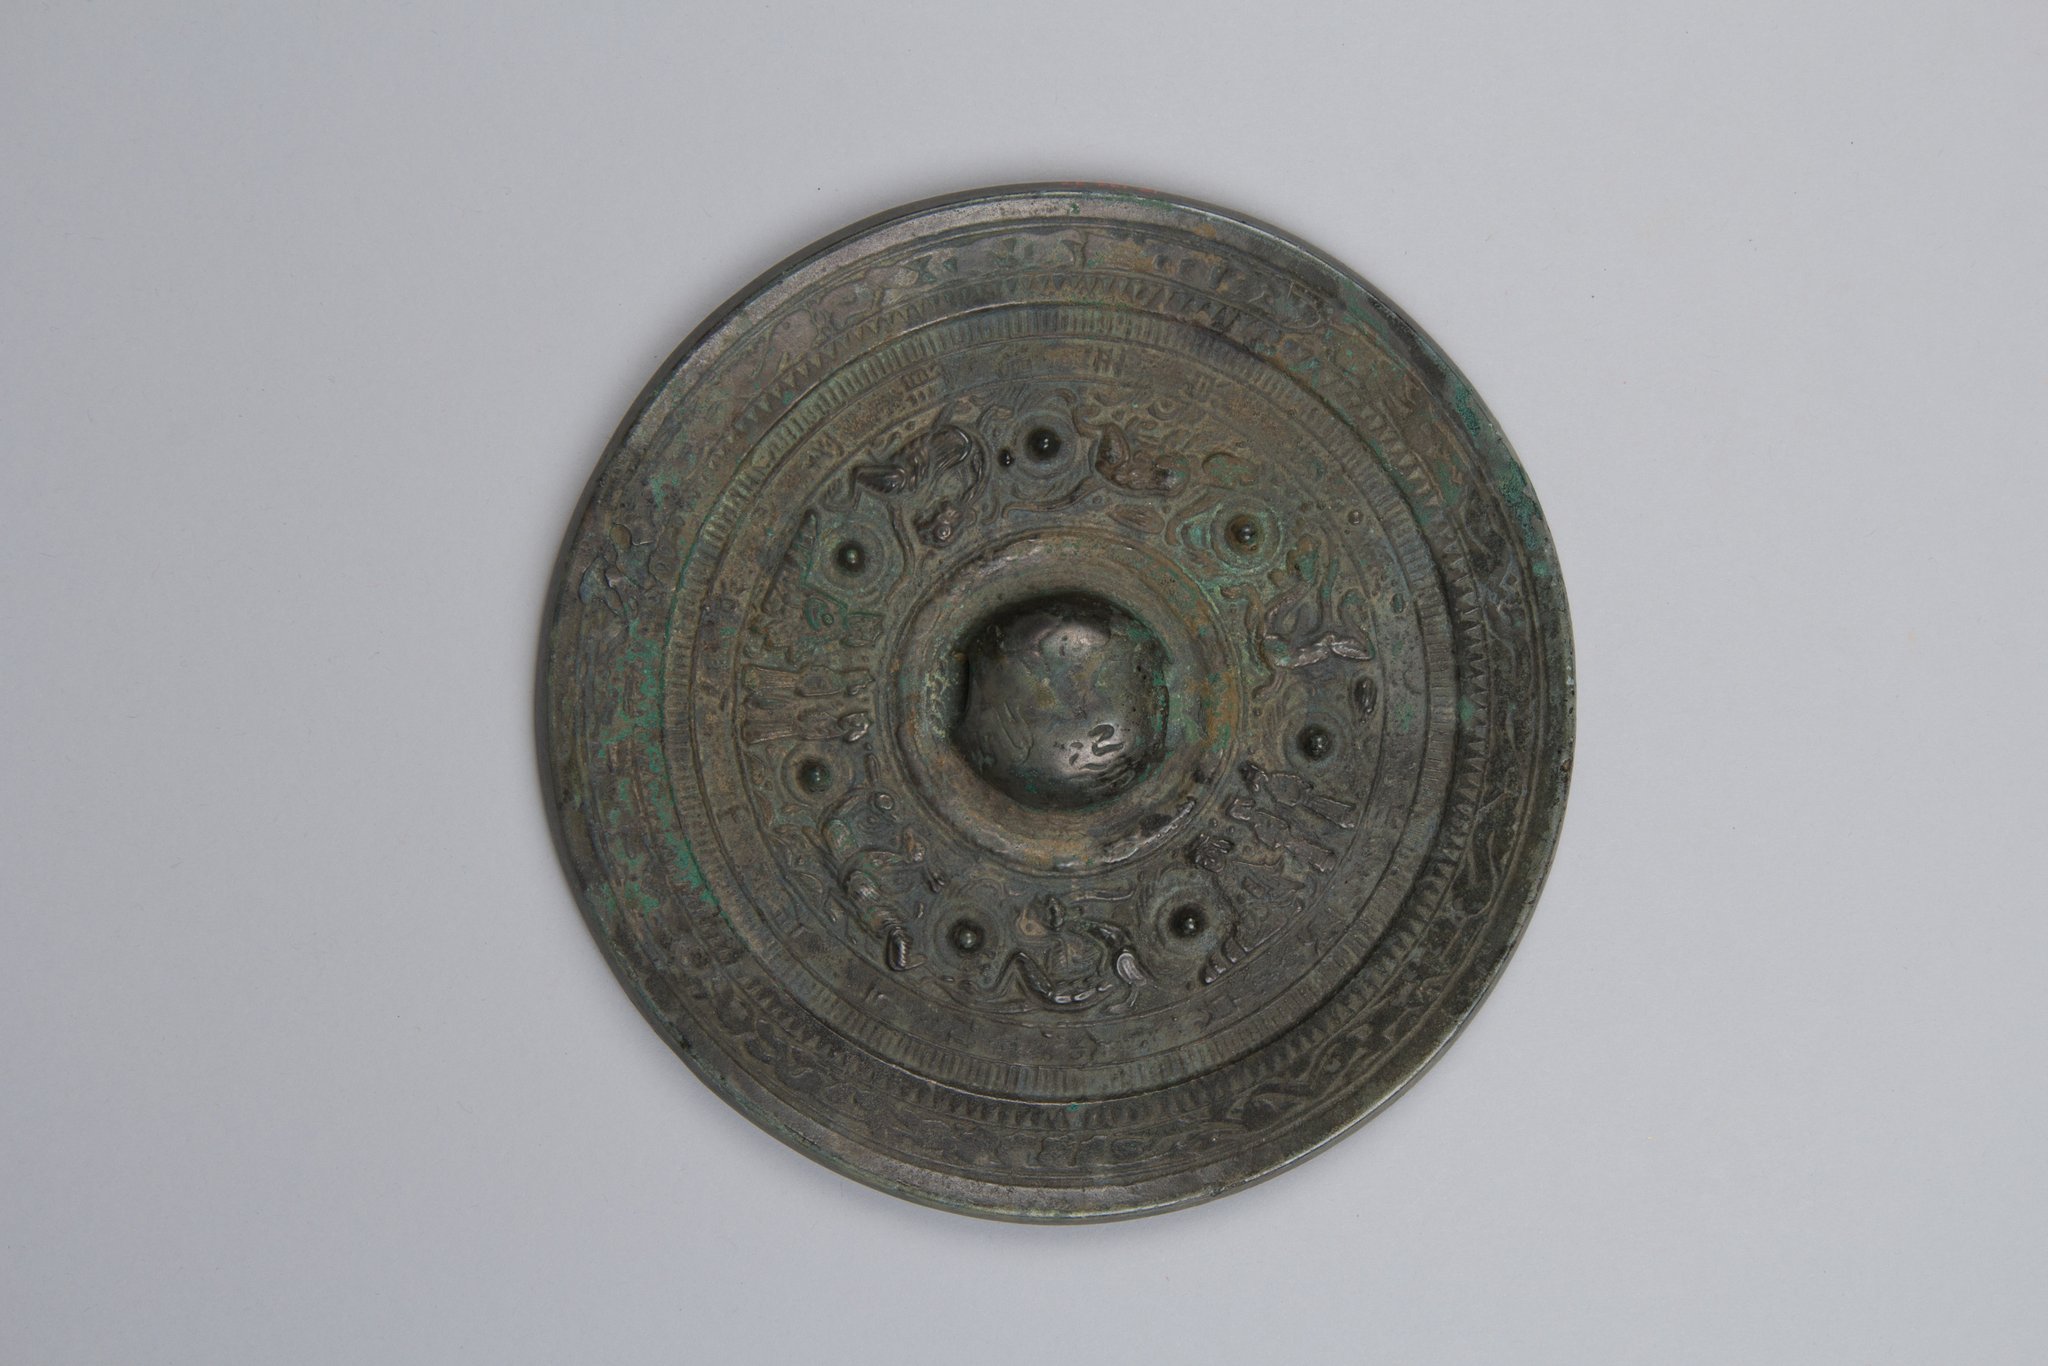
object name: mirror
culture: chinese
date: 201-300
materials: bronze